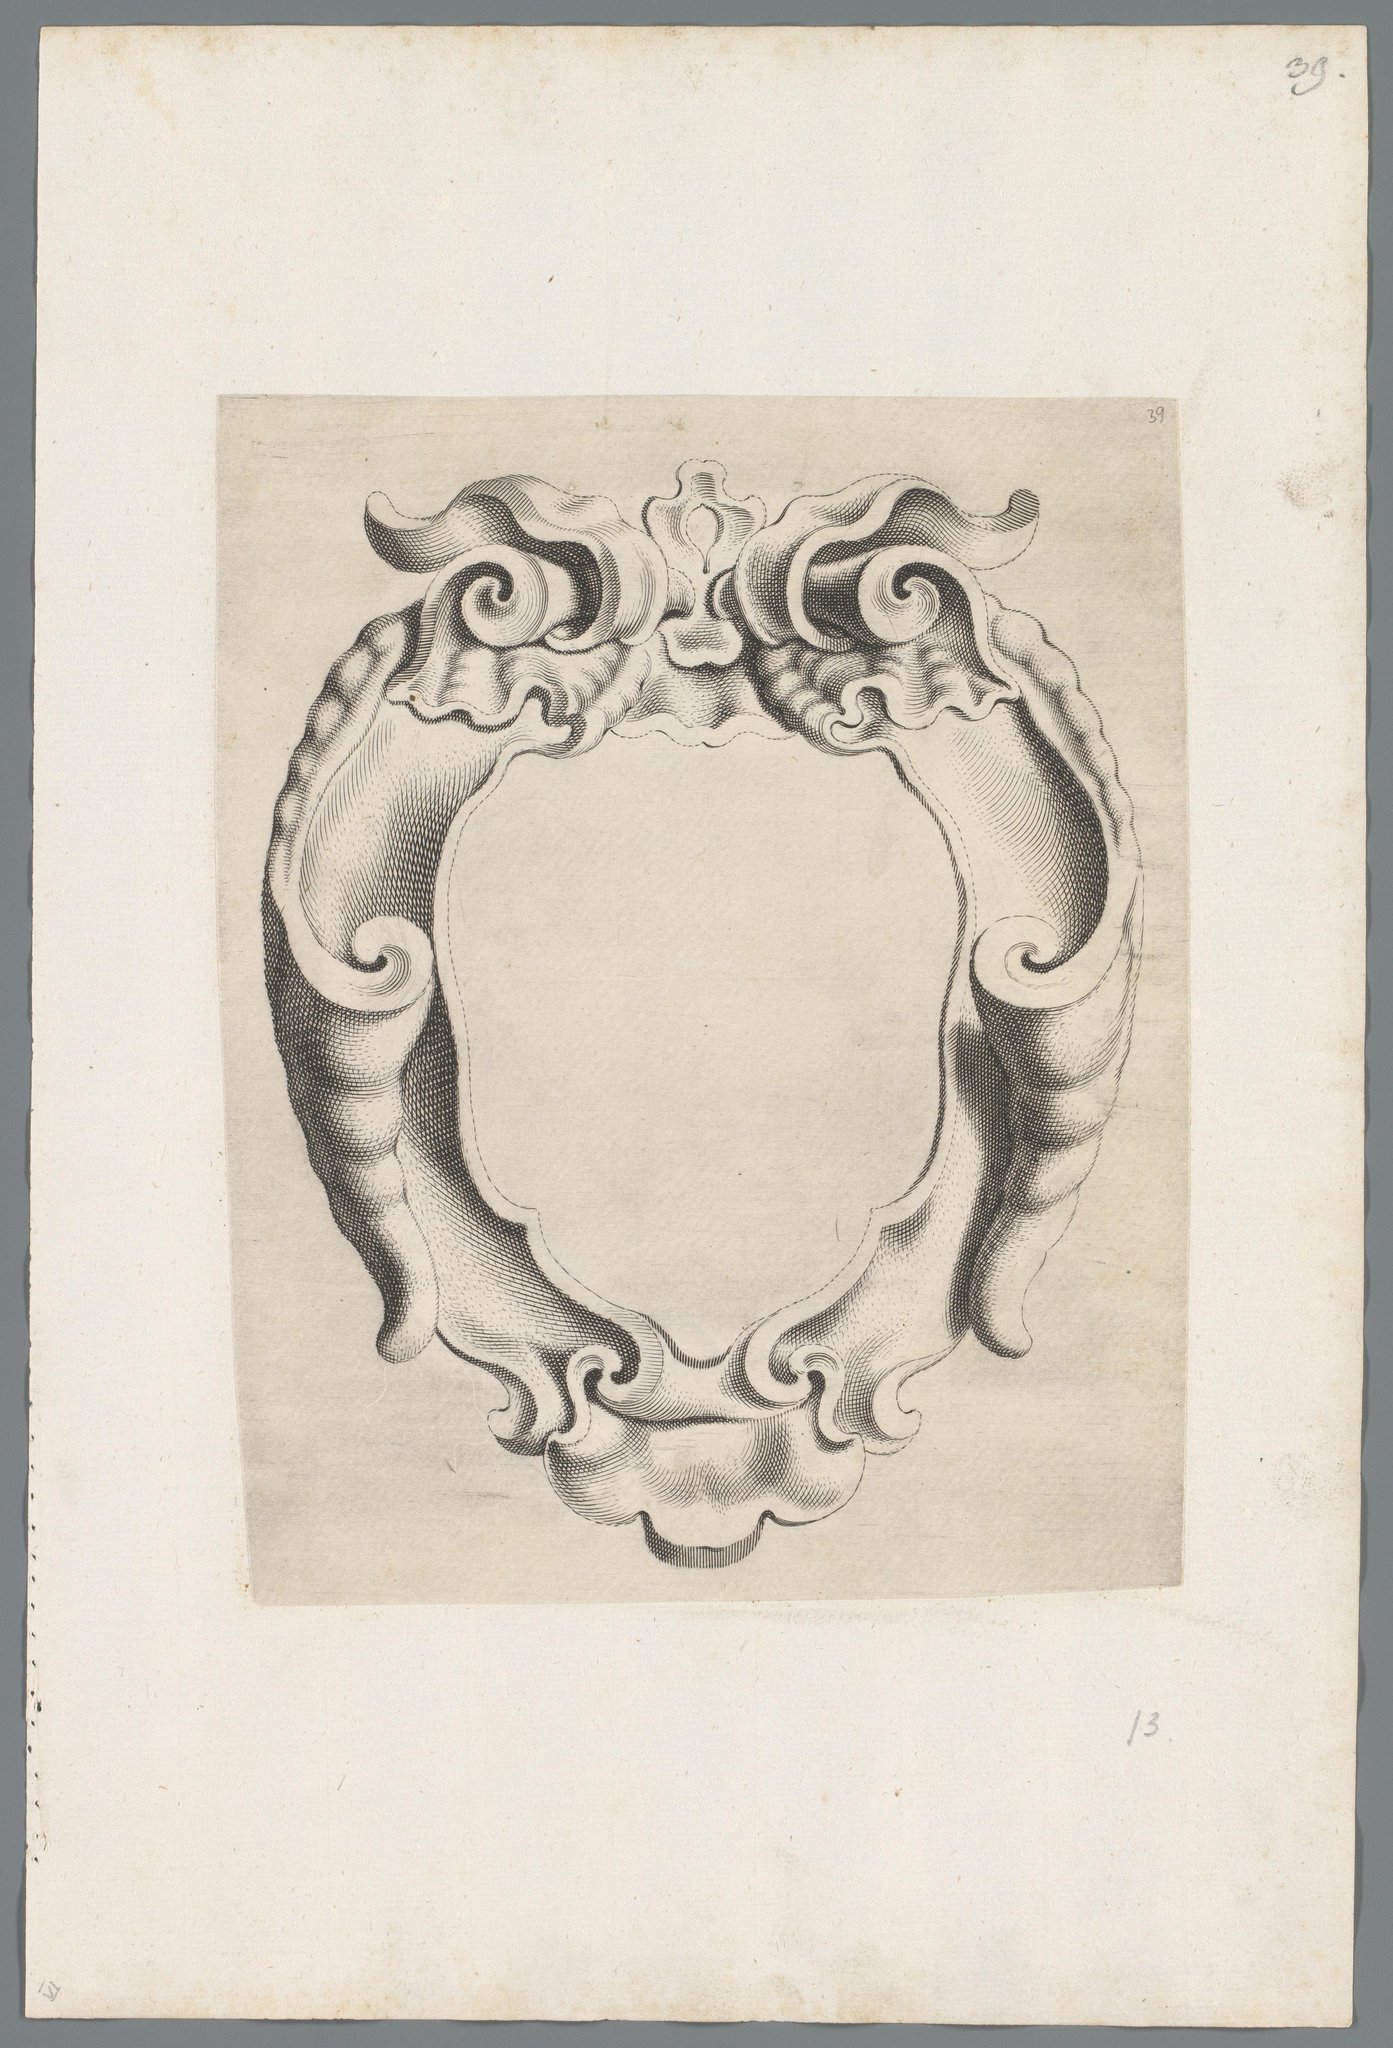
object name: ornament print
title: Diverse nieuwe cartouches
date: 1640-1674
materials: paper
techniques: engraving, etching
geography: amsterdam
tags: auricular ornament, lobe style ~ ornament, ornament ~ cartouche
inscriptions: collector's mark: Lugt 2760, collector's mark: Lugt 2228